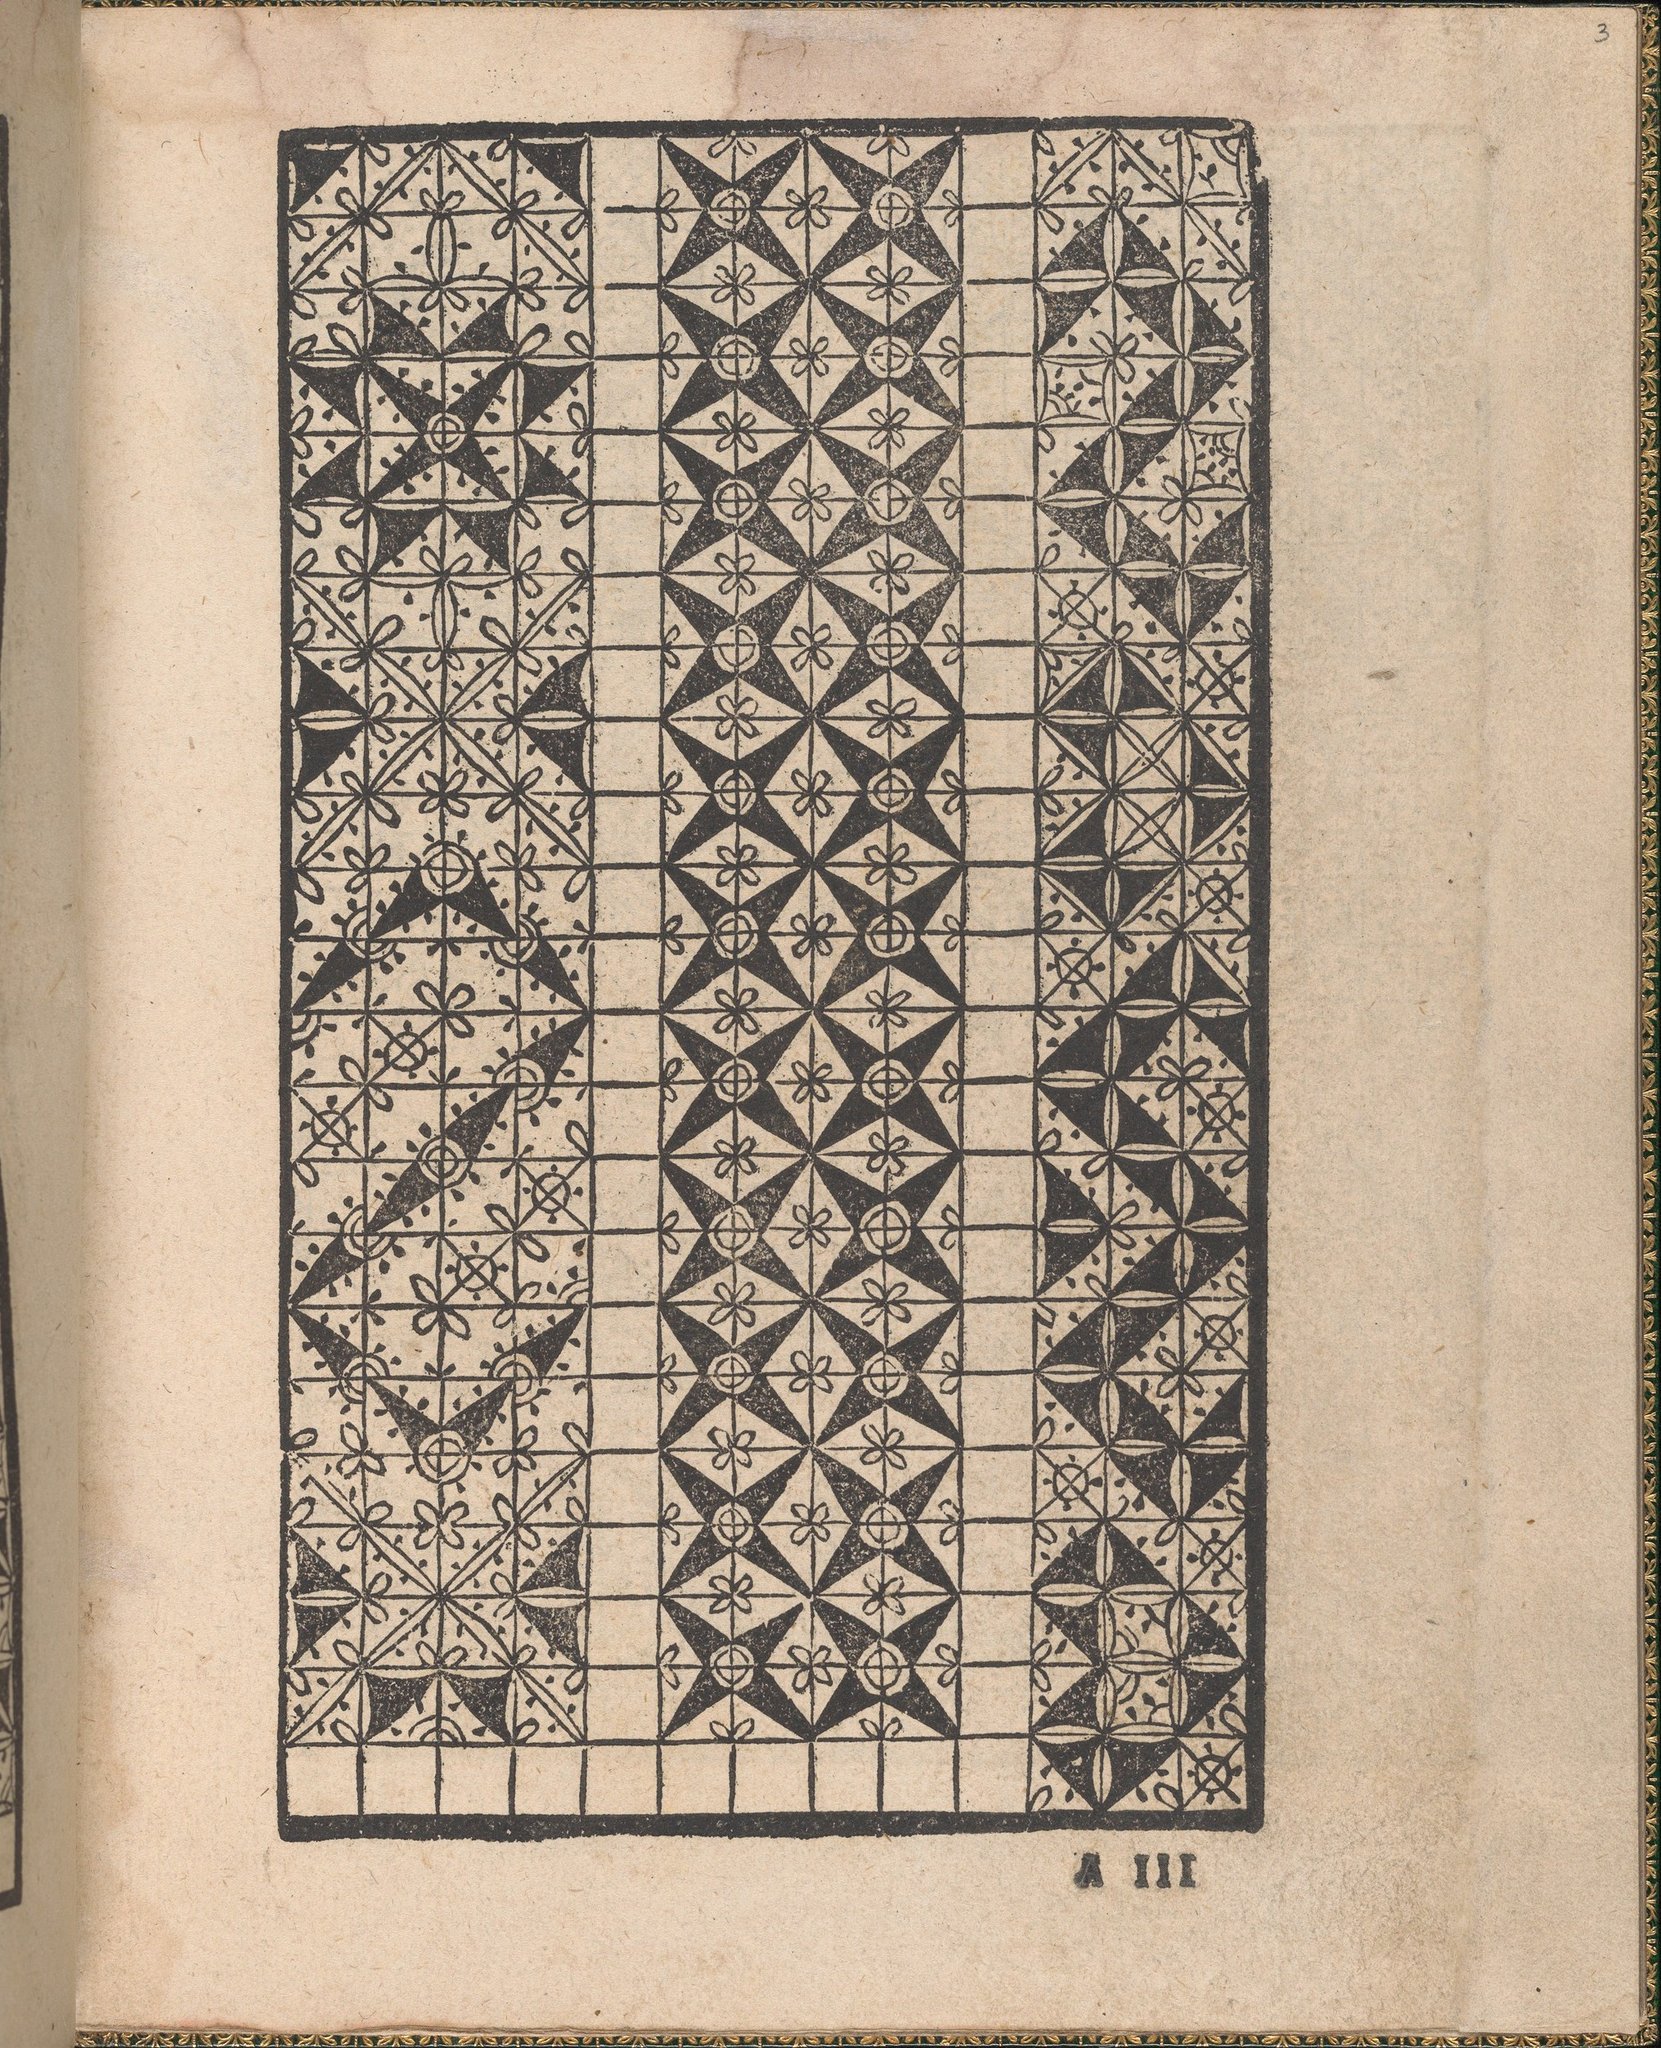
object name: book print ornament architecture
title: Ornamento delle belle & virtuose donne, page 2 (verso)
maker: matteo pagano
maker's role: publisher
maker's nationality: italian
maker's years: 1515-1588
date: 1554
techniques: woodcut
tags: ornament